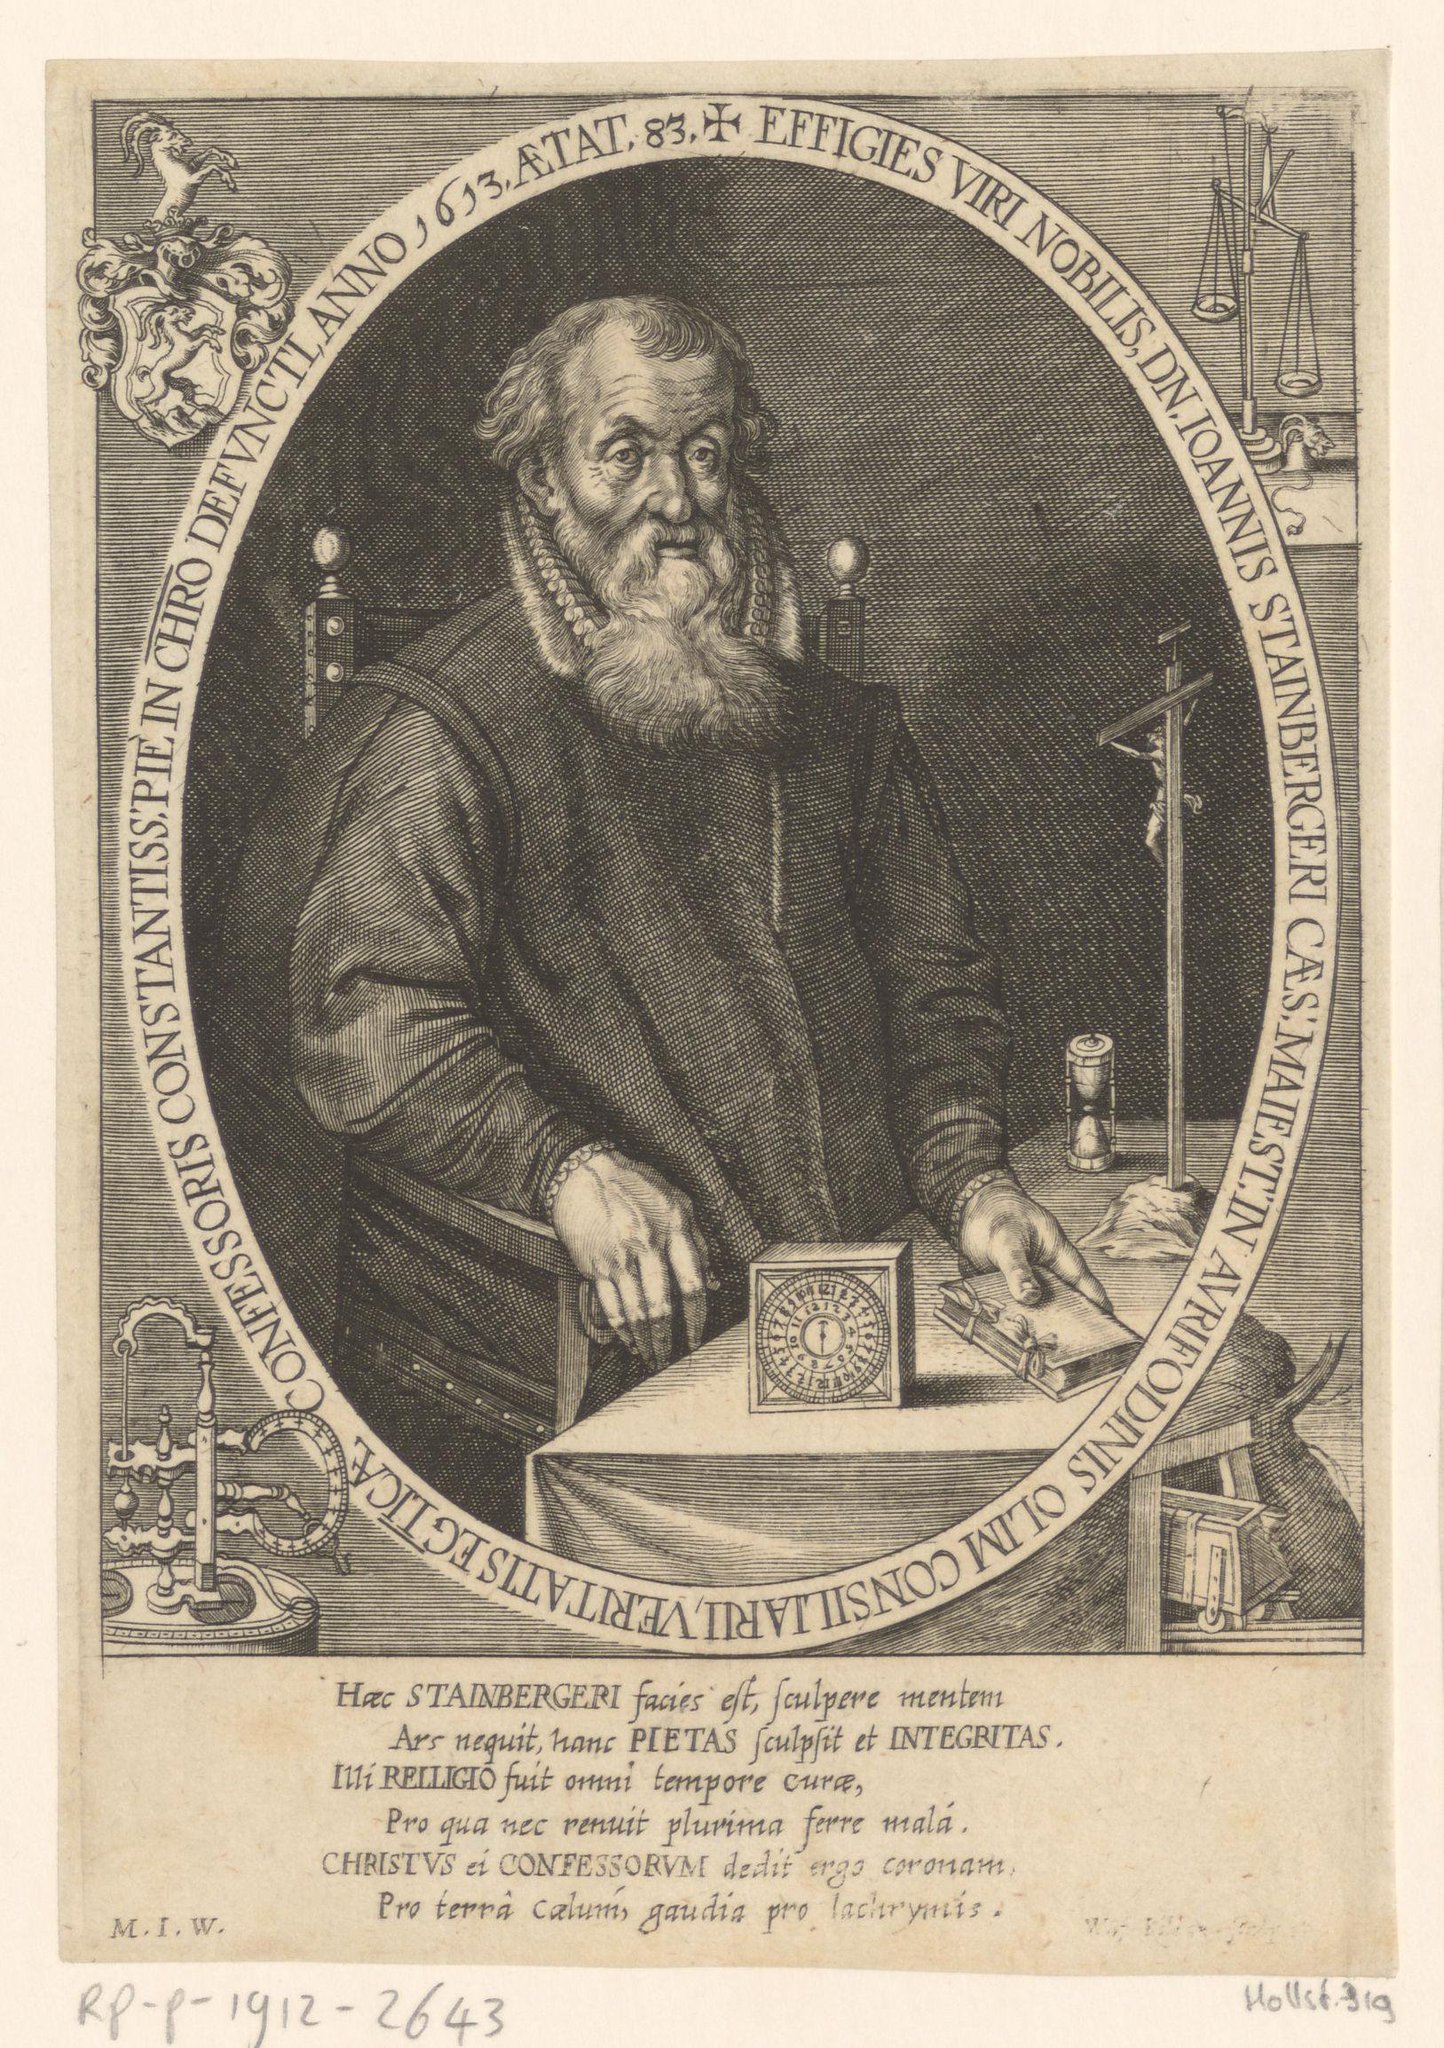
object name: print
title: Portret van Johann Stainberger op 83-jarige leeftijd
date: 1613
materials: paper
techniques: engraving, etching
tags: historical persons, measuring-instruments, politician, e.g. party leader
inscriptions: collector's mark: Lugt 2228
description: Tekst in het Latijn in de omlijsting en in de ondermarge.